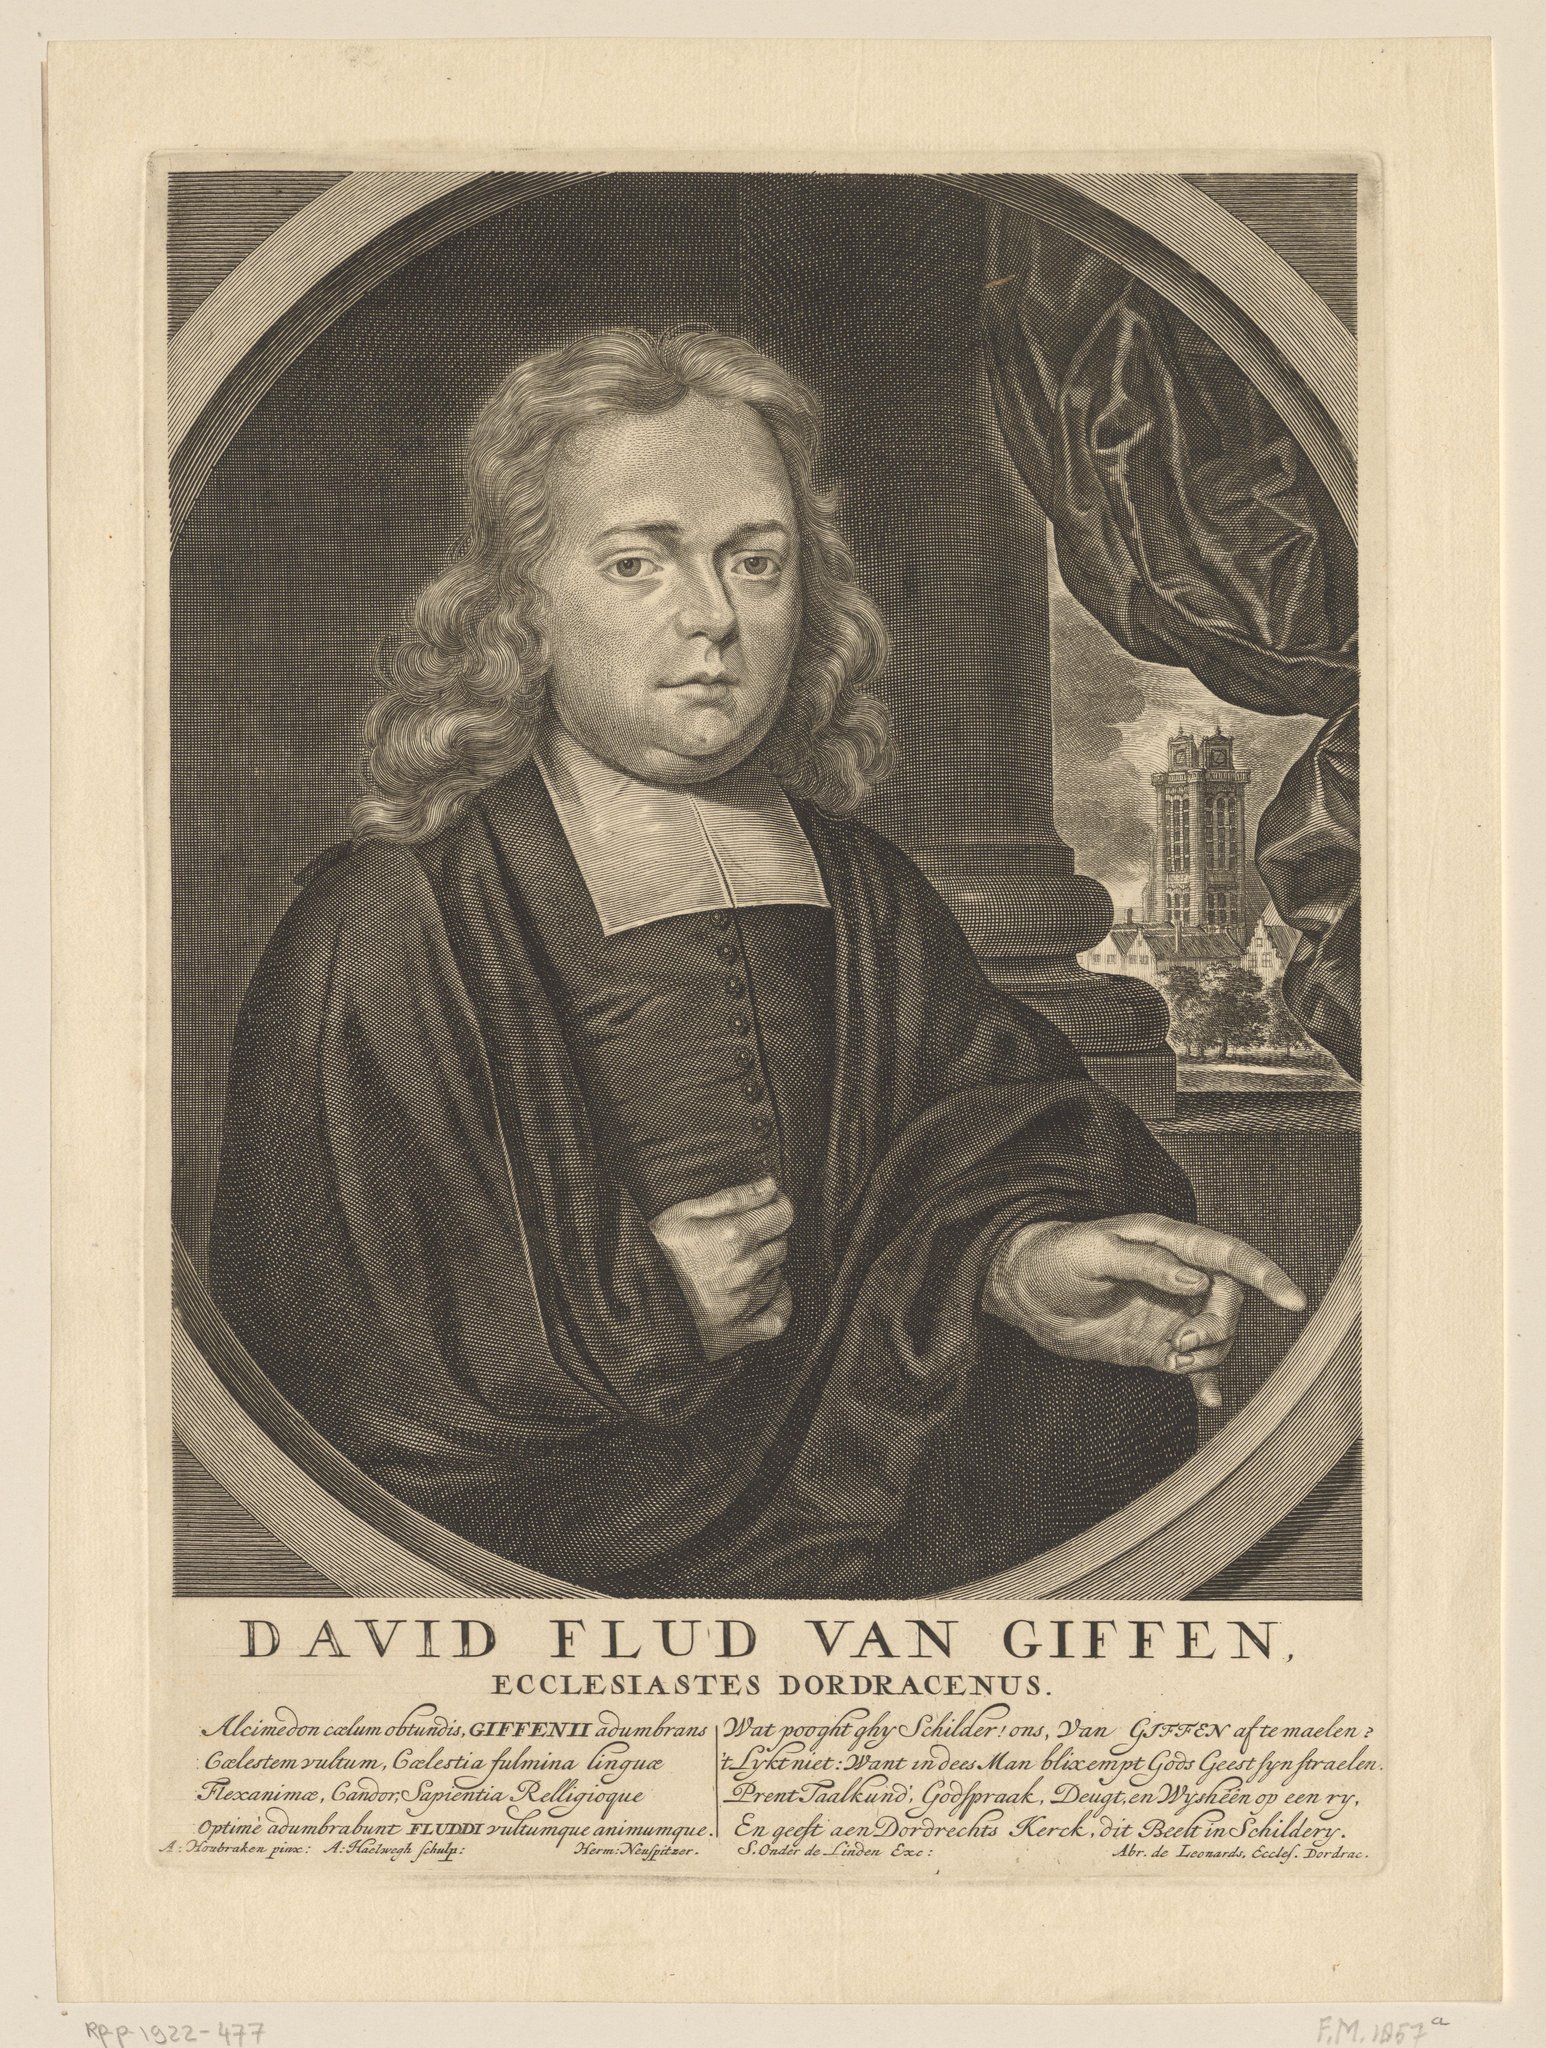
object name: print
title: Portret van David Flud van Giffen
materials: paper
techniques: engraving, etching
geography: dordrecht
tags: theologian, historical persons, building of church, professor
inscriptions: collector's mark: Lugt 2233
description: Tekst in het Latijn en het Nederlands in de ondermarge.